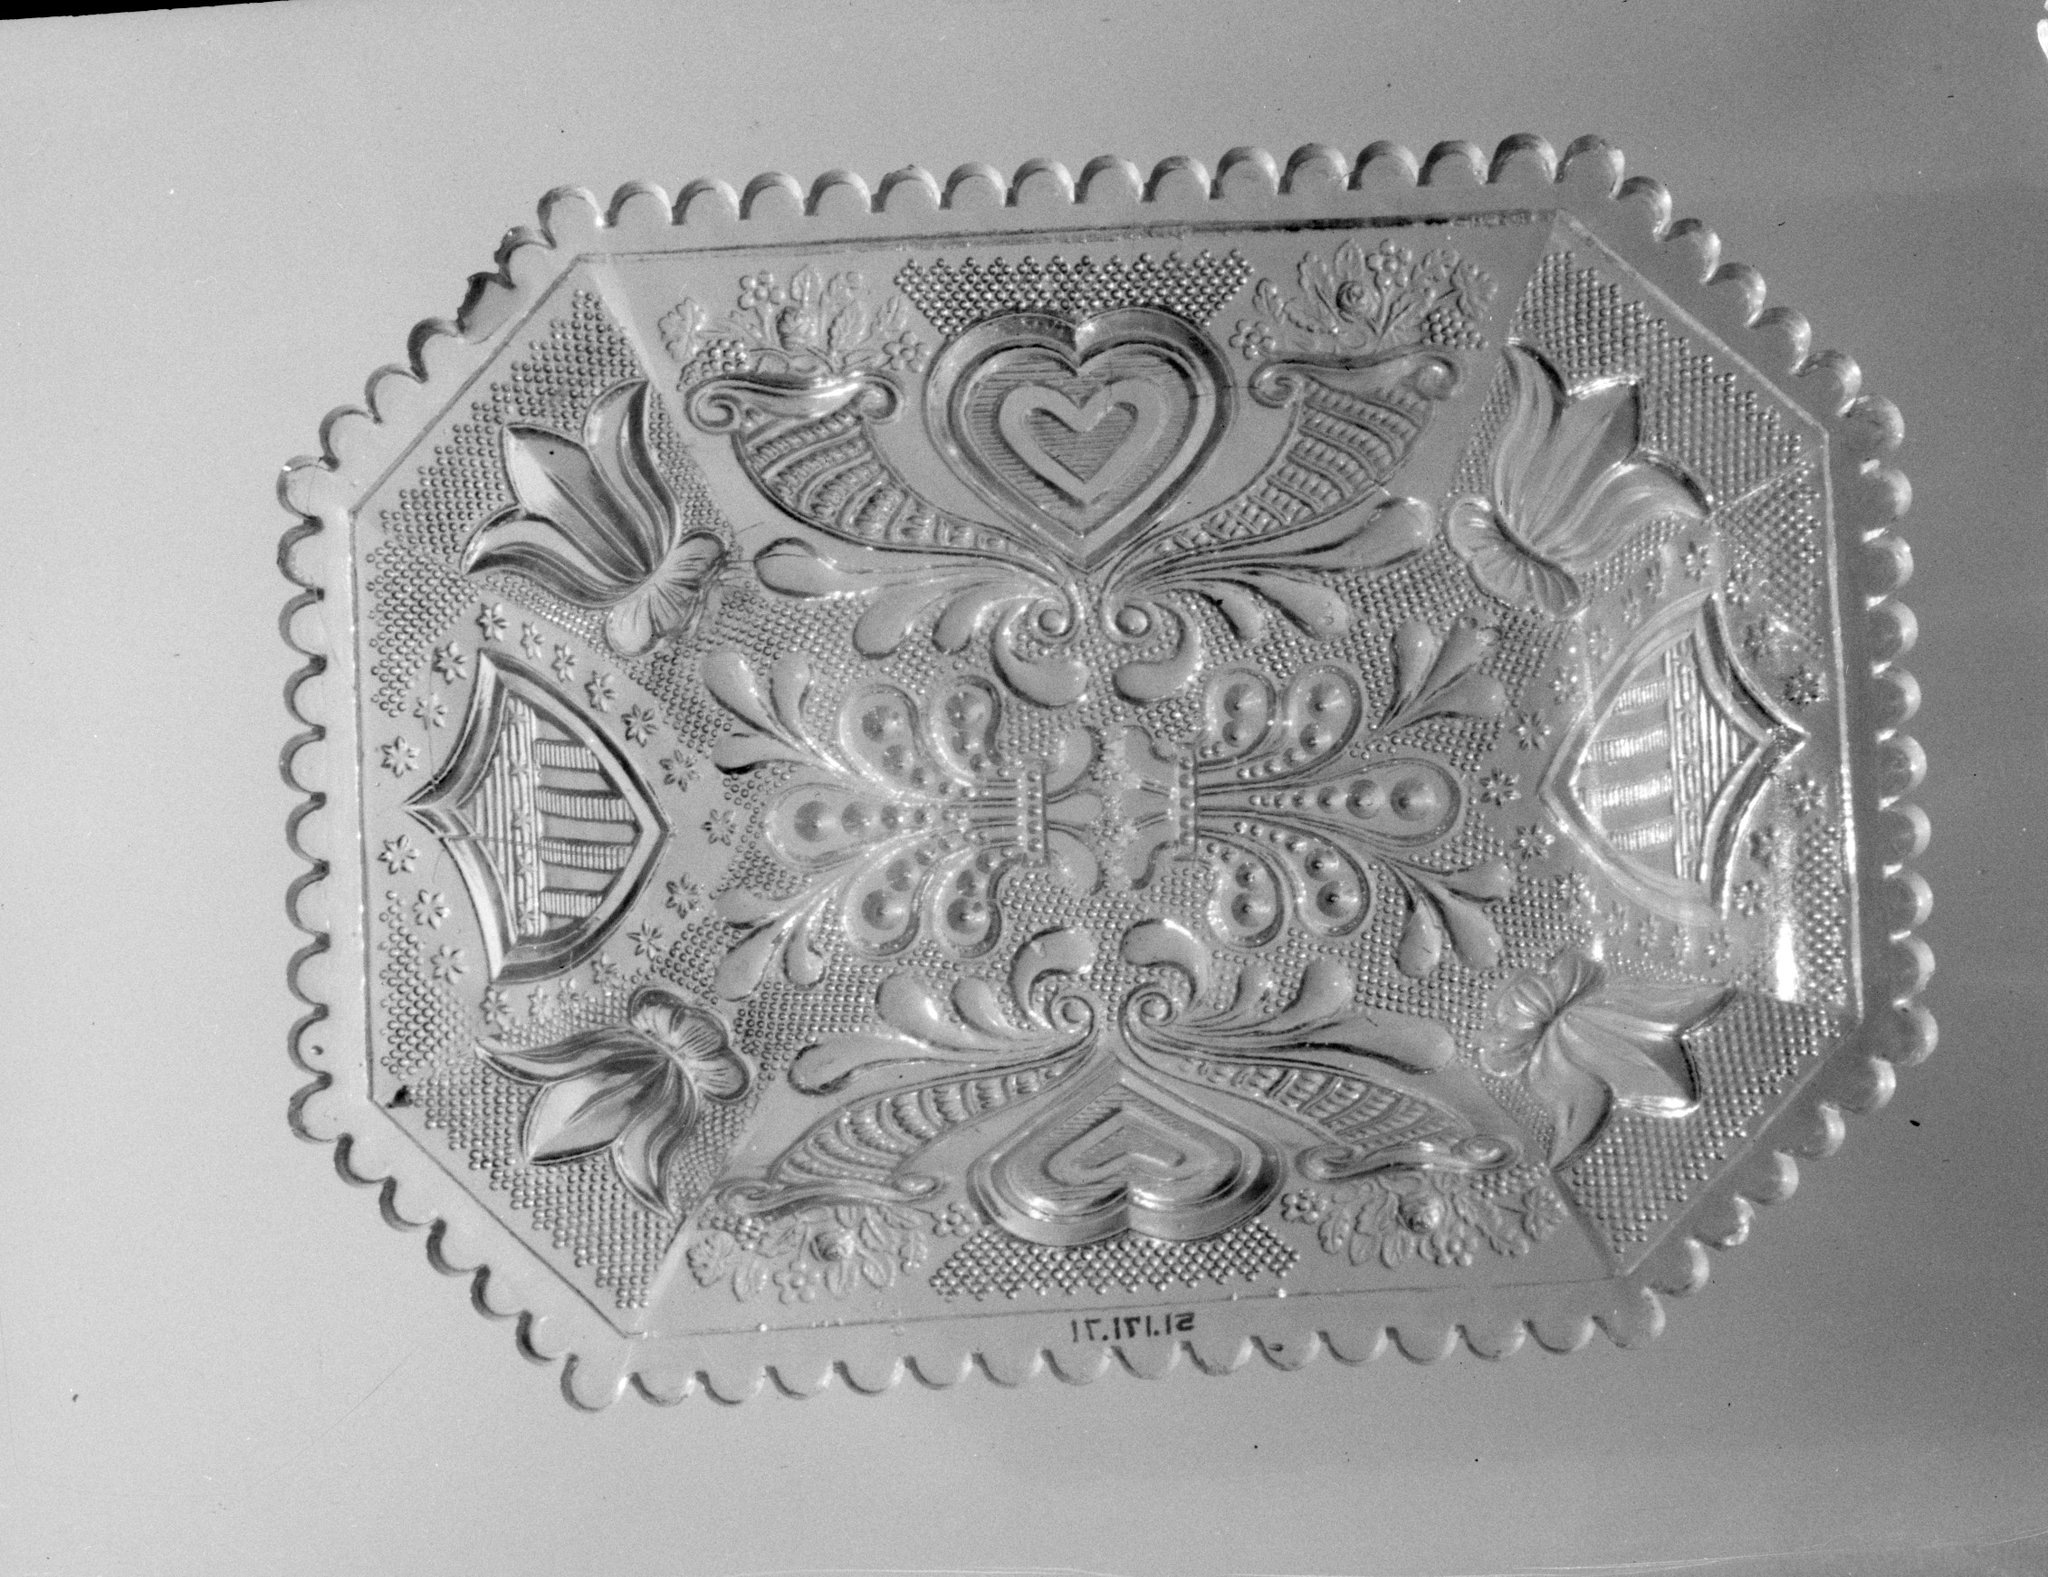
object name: dish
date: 1830-1900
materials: glass